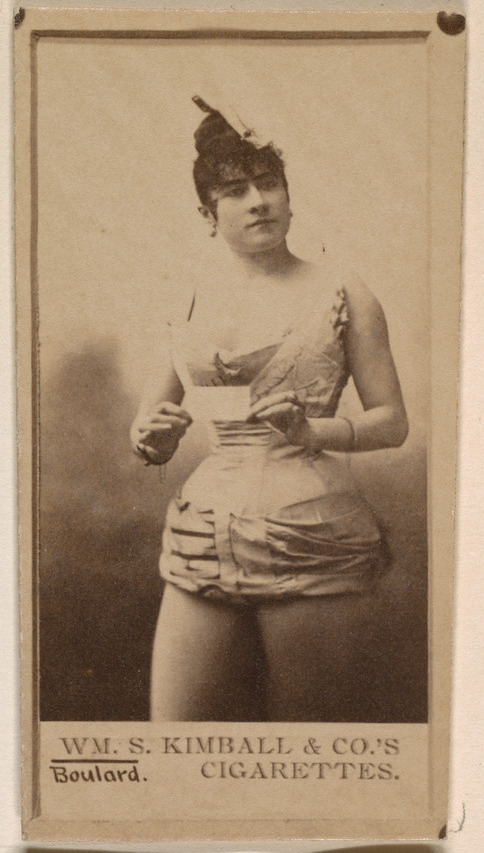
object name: photograph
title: Miss Boulard, from the Actresses series (N203) issued by Wm. S. Kimball & Co.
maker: william s. kimball & company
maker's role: publisher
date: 1889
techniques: color lithograph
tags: portraits,women,actresses